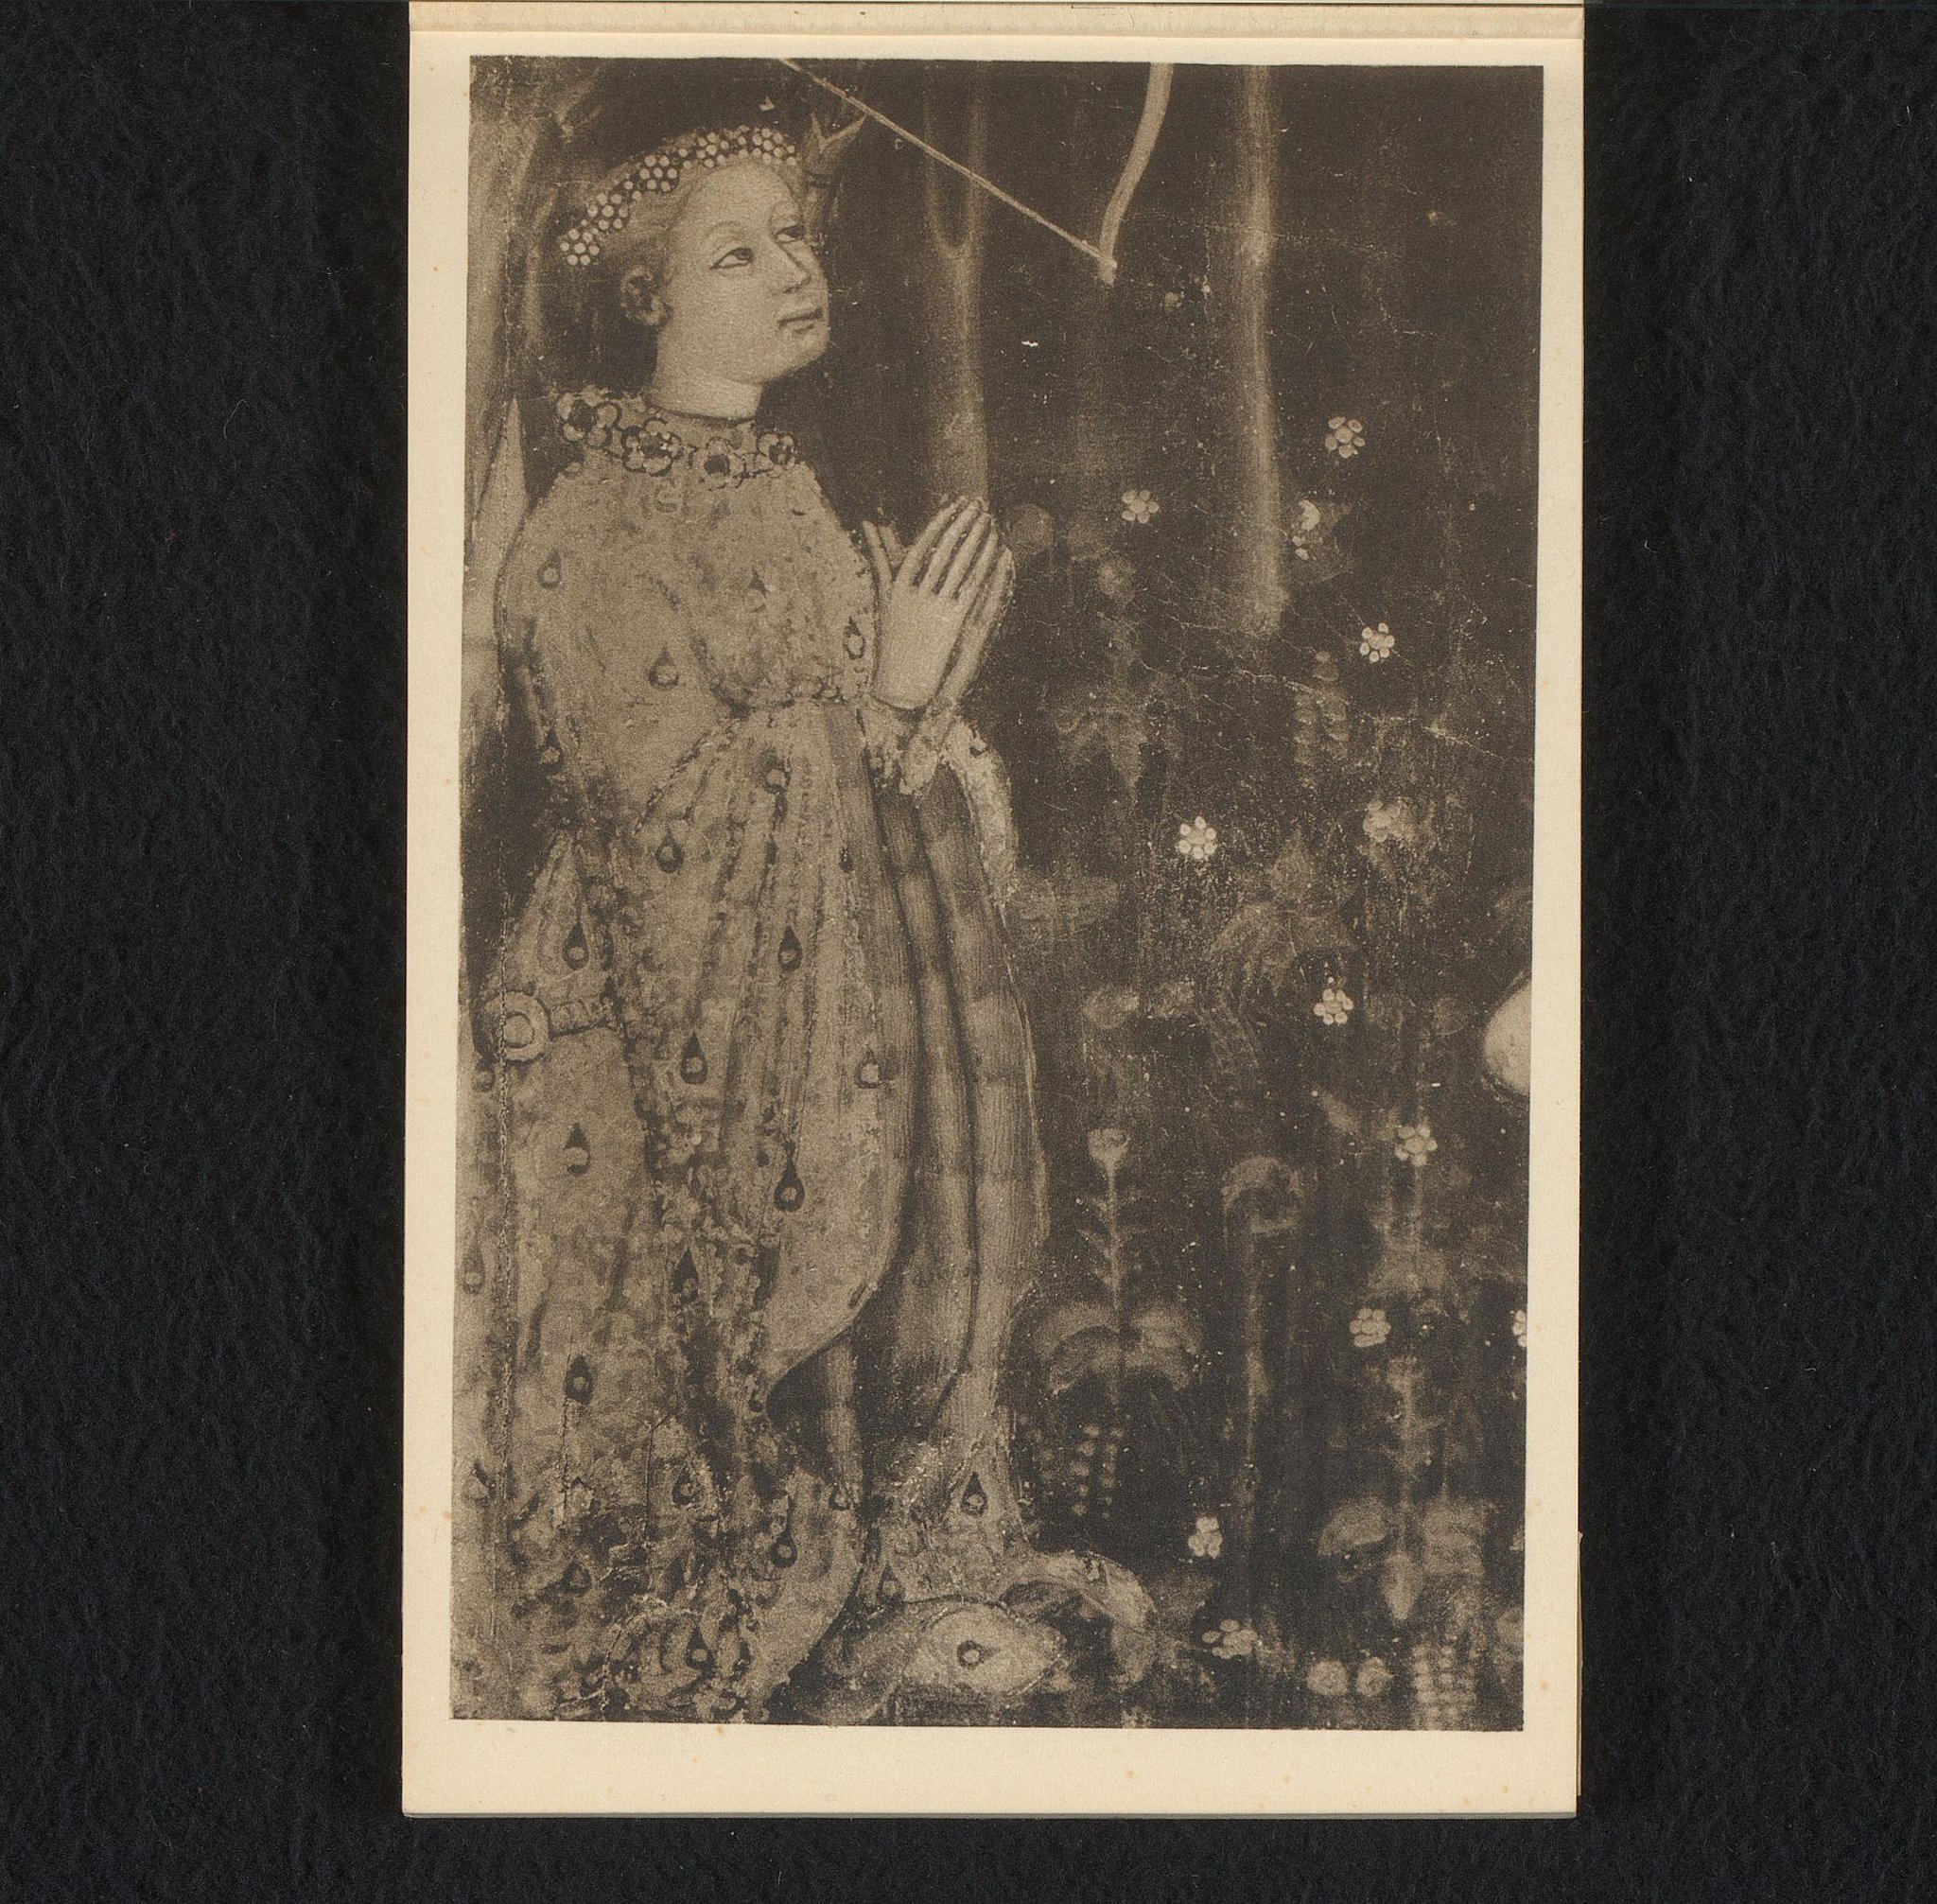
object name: ansichtkaart, prentbriefkaart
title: Museo Cerralbo. Madrid. Don Gastón de la Cerda, cuarto Conde de Medinaceli, Capitán General de la frontera de Aragón, casado con una hija del primer Marqués de Santillana y muerto en 1454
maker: Anonymous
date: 1924-1930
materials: cardboard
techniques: photograph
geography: madrid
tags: permanent exhibition, museum, picture, painting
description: Prentbriefkaart maakt deel uit van een album.